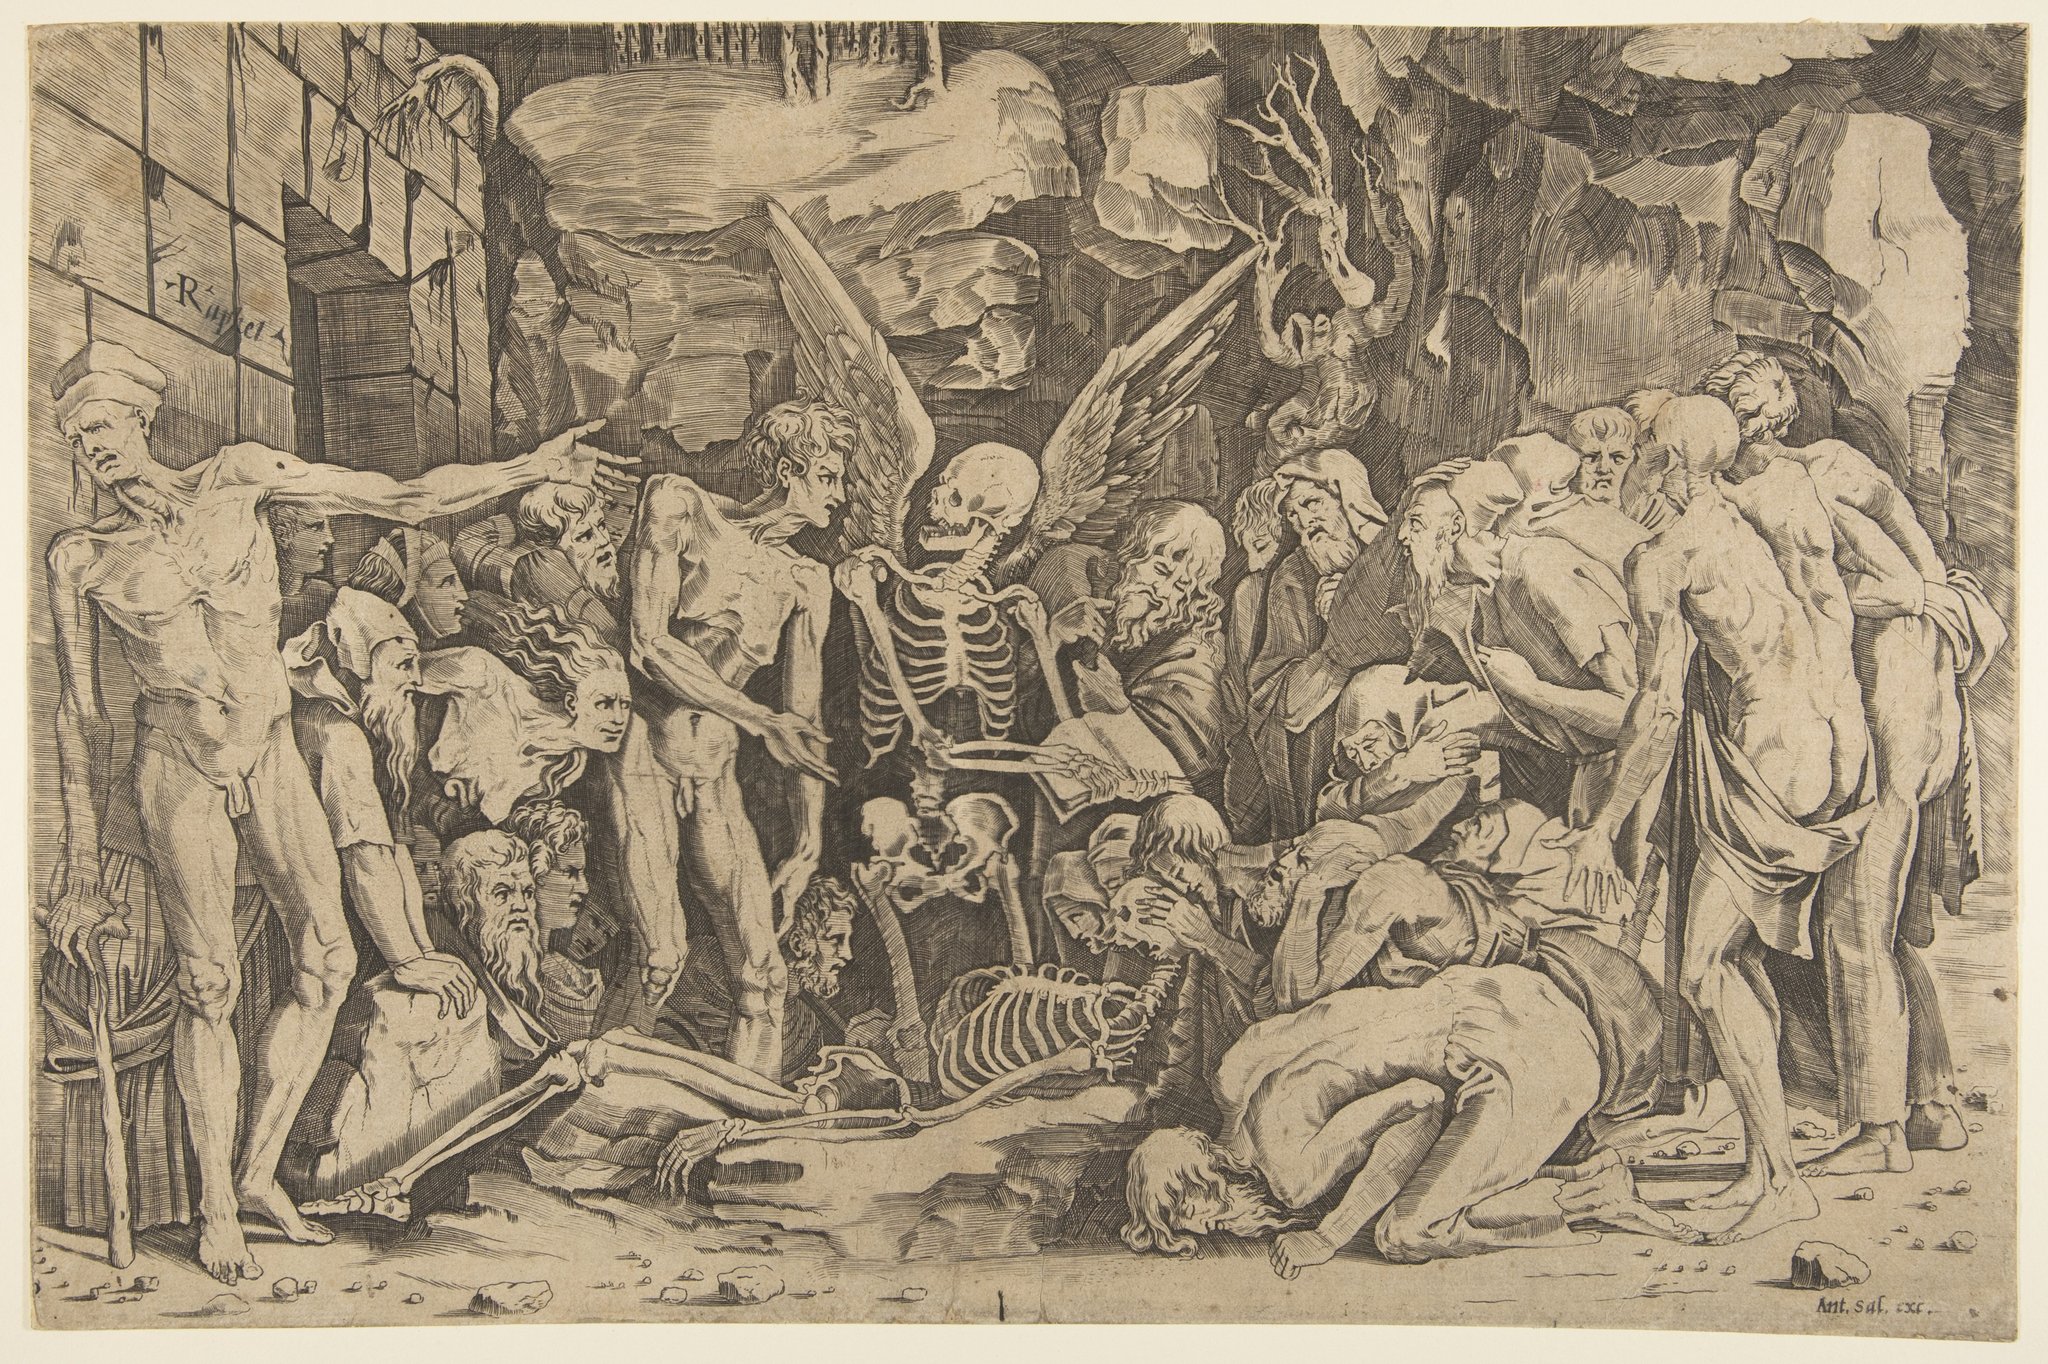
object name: print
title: The Skeletons, a group of emaciated men and women gathered around a skeleton laid on the ground and a figure of Death as a winged skeleton standing above it holding an open book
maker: marco dente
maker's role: artist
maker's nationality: italian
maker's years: 1515-1527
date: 1515-1527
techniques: engraving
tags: books,skeletons,male nudes,women,death